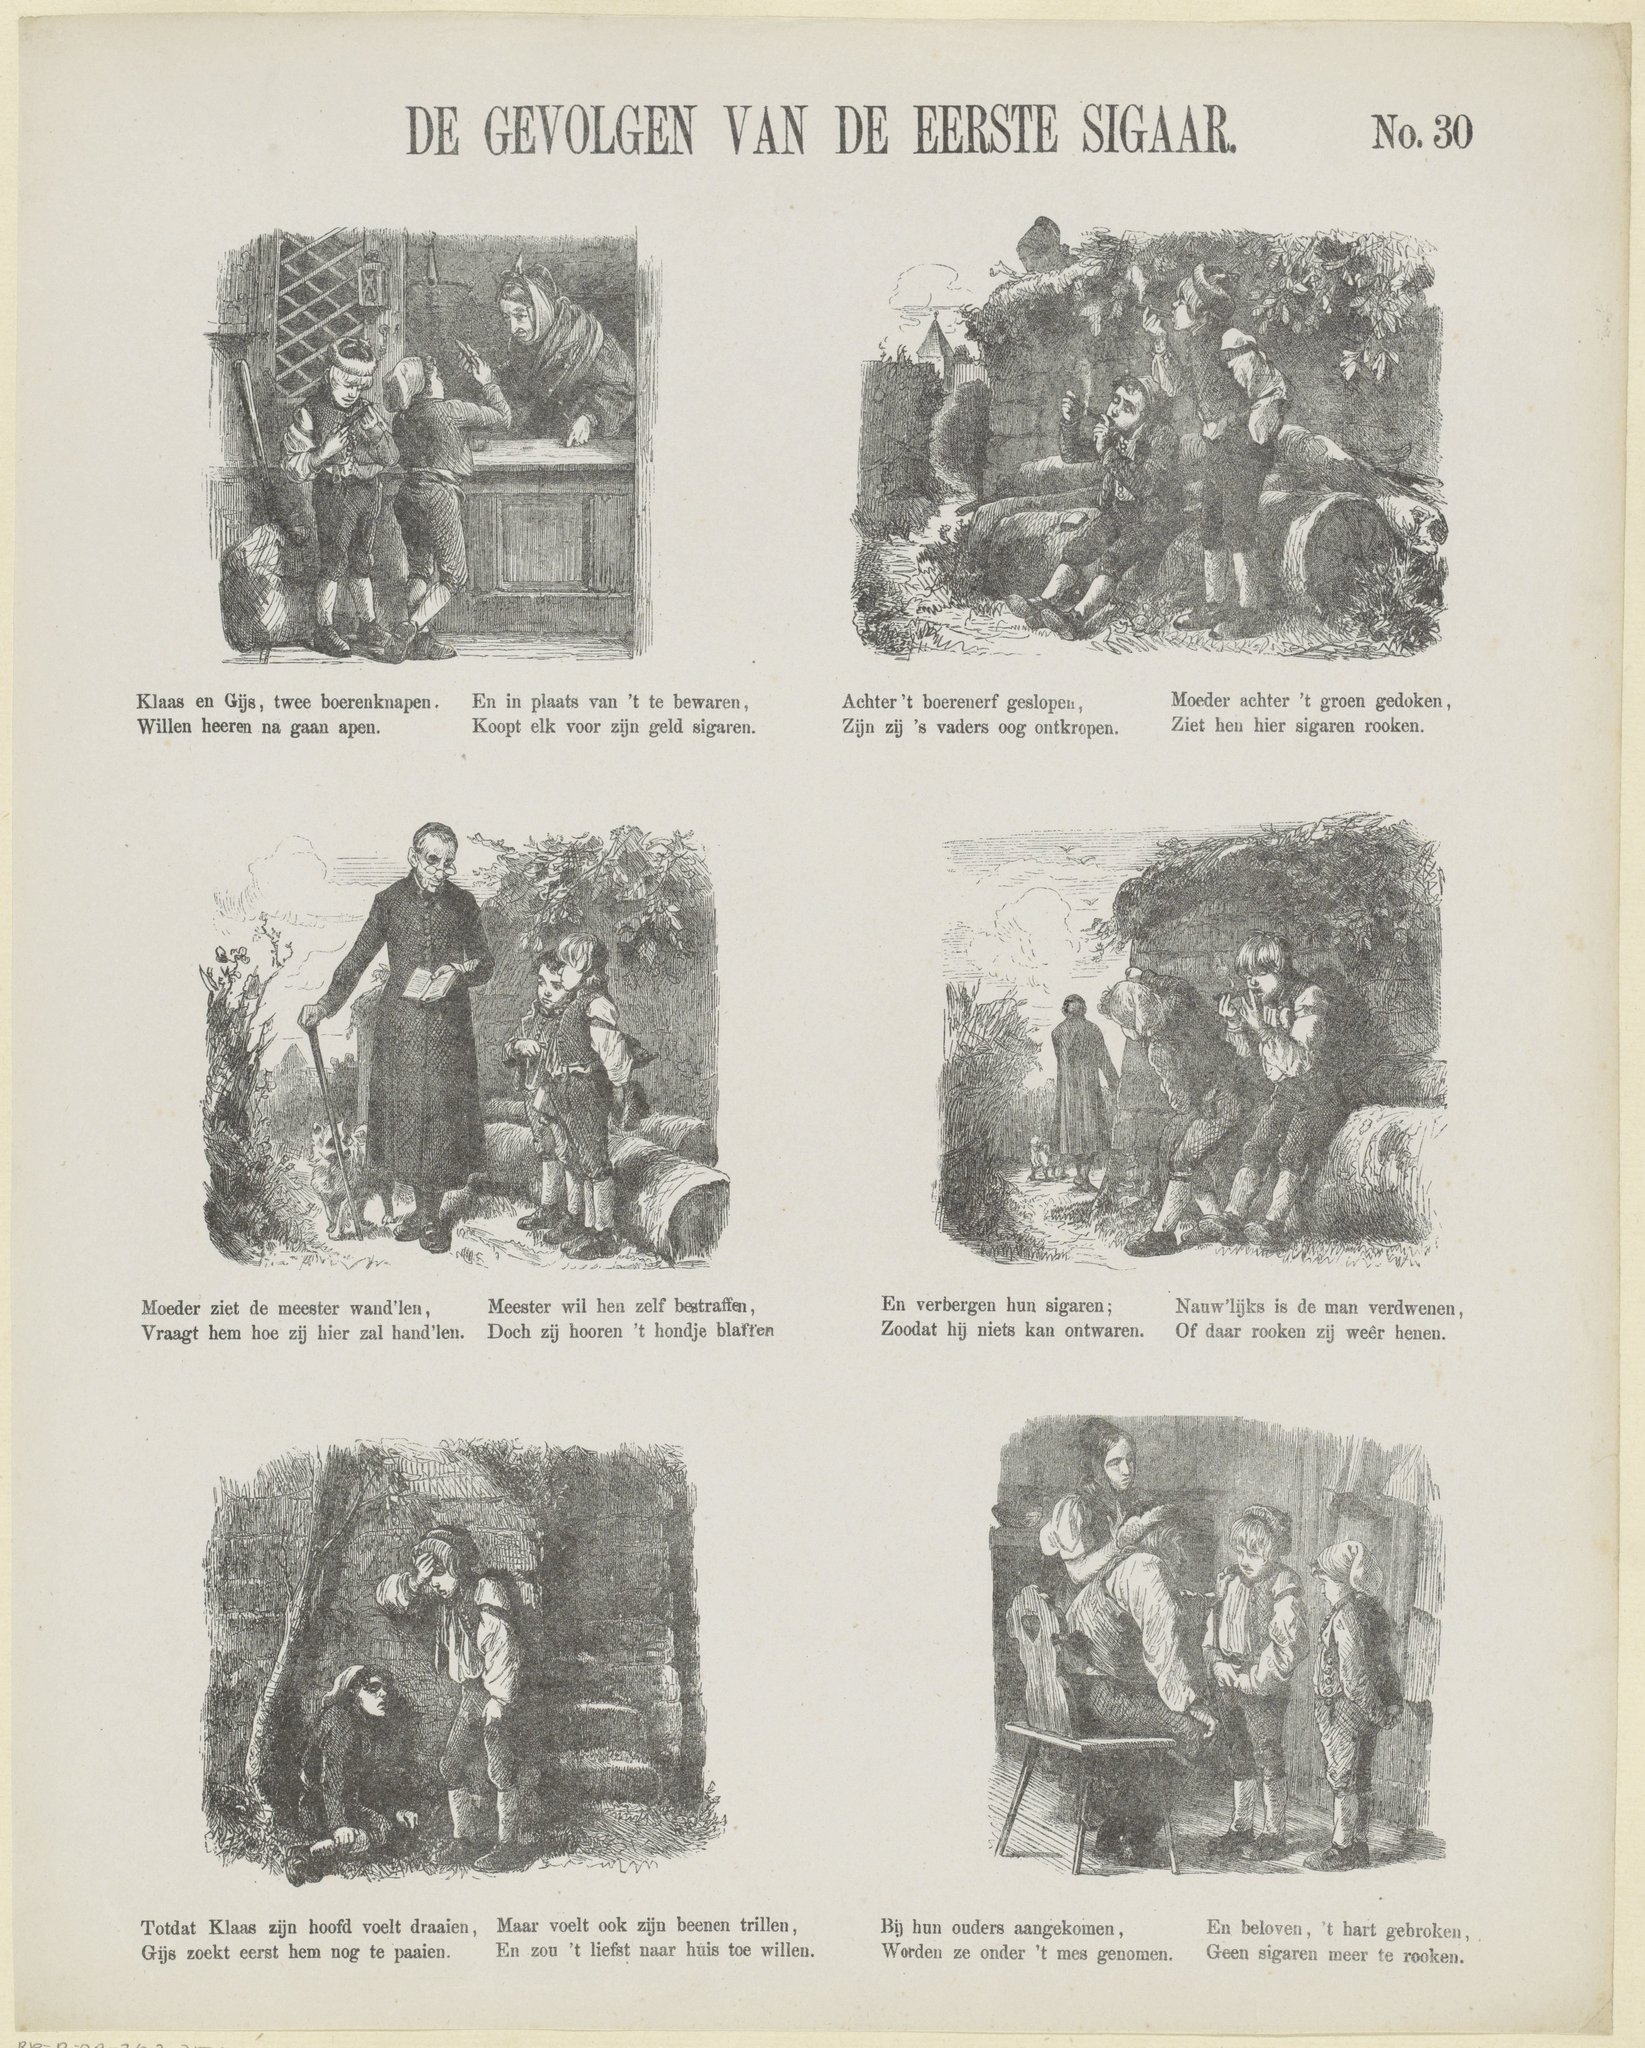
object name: popular print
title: Meijer's prenten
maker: Anonymous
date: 1874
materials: paper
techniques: letterpress printing, lithograph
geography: amsterdam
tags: cigar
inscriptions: collector's mark: Lugt 2760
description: Blad met 6 voorstellingen over twee jongens, Klaas en Gijs, die sigaren kopen en deze roken. Het bekomt ze slecht. Ze beloven hun ouders geen sigaren meer te roken. Onder elke afbeelding een vierregelig vers in twee kolommen. Genummerd rechtsboven: No. 30.